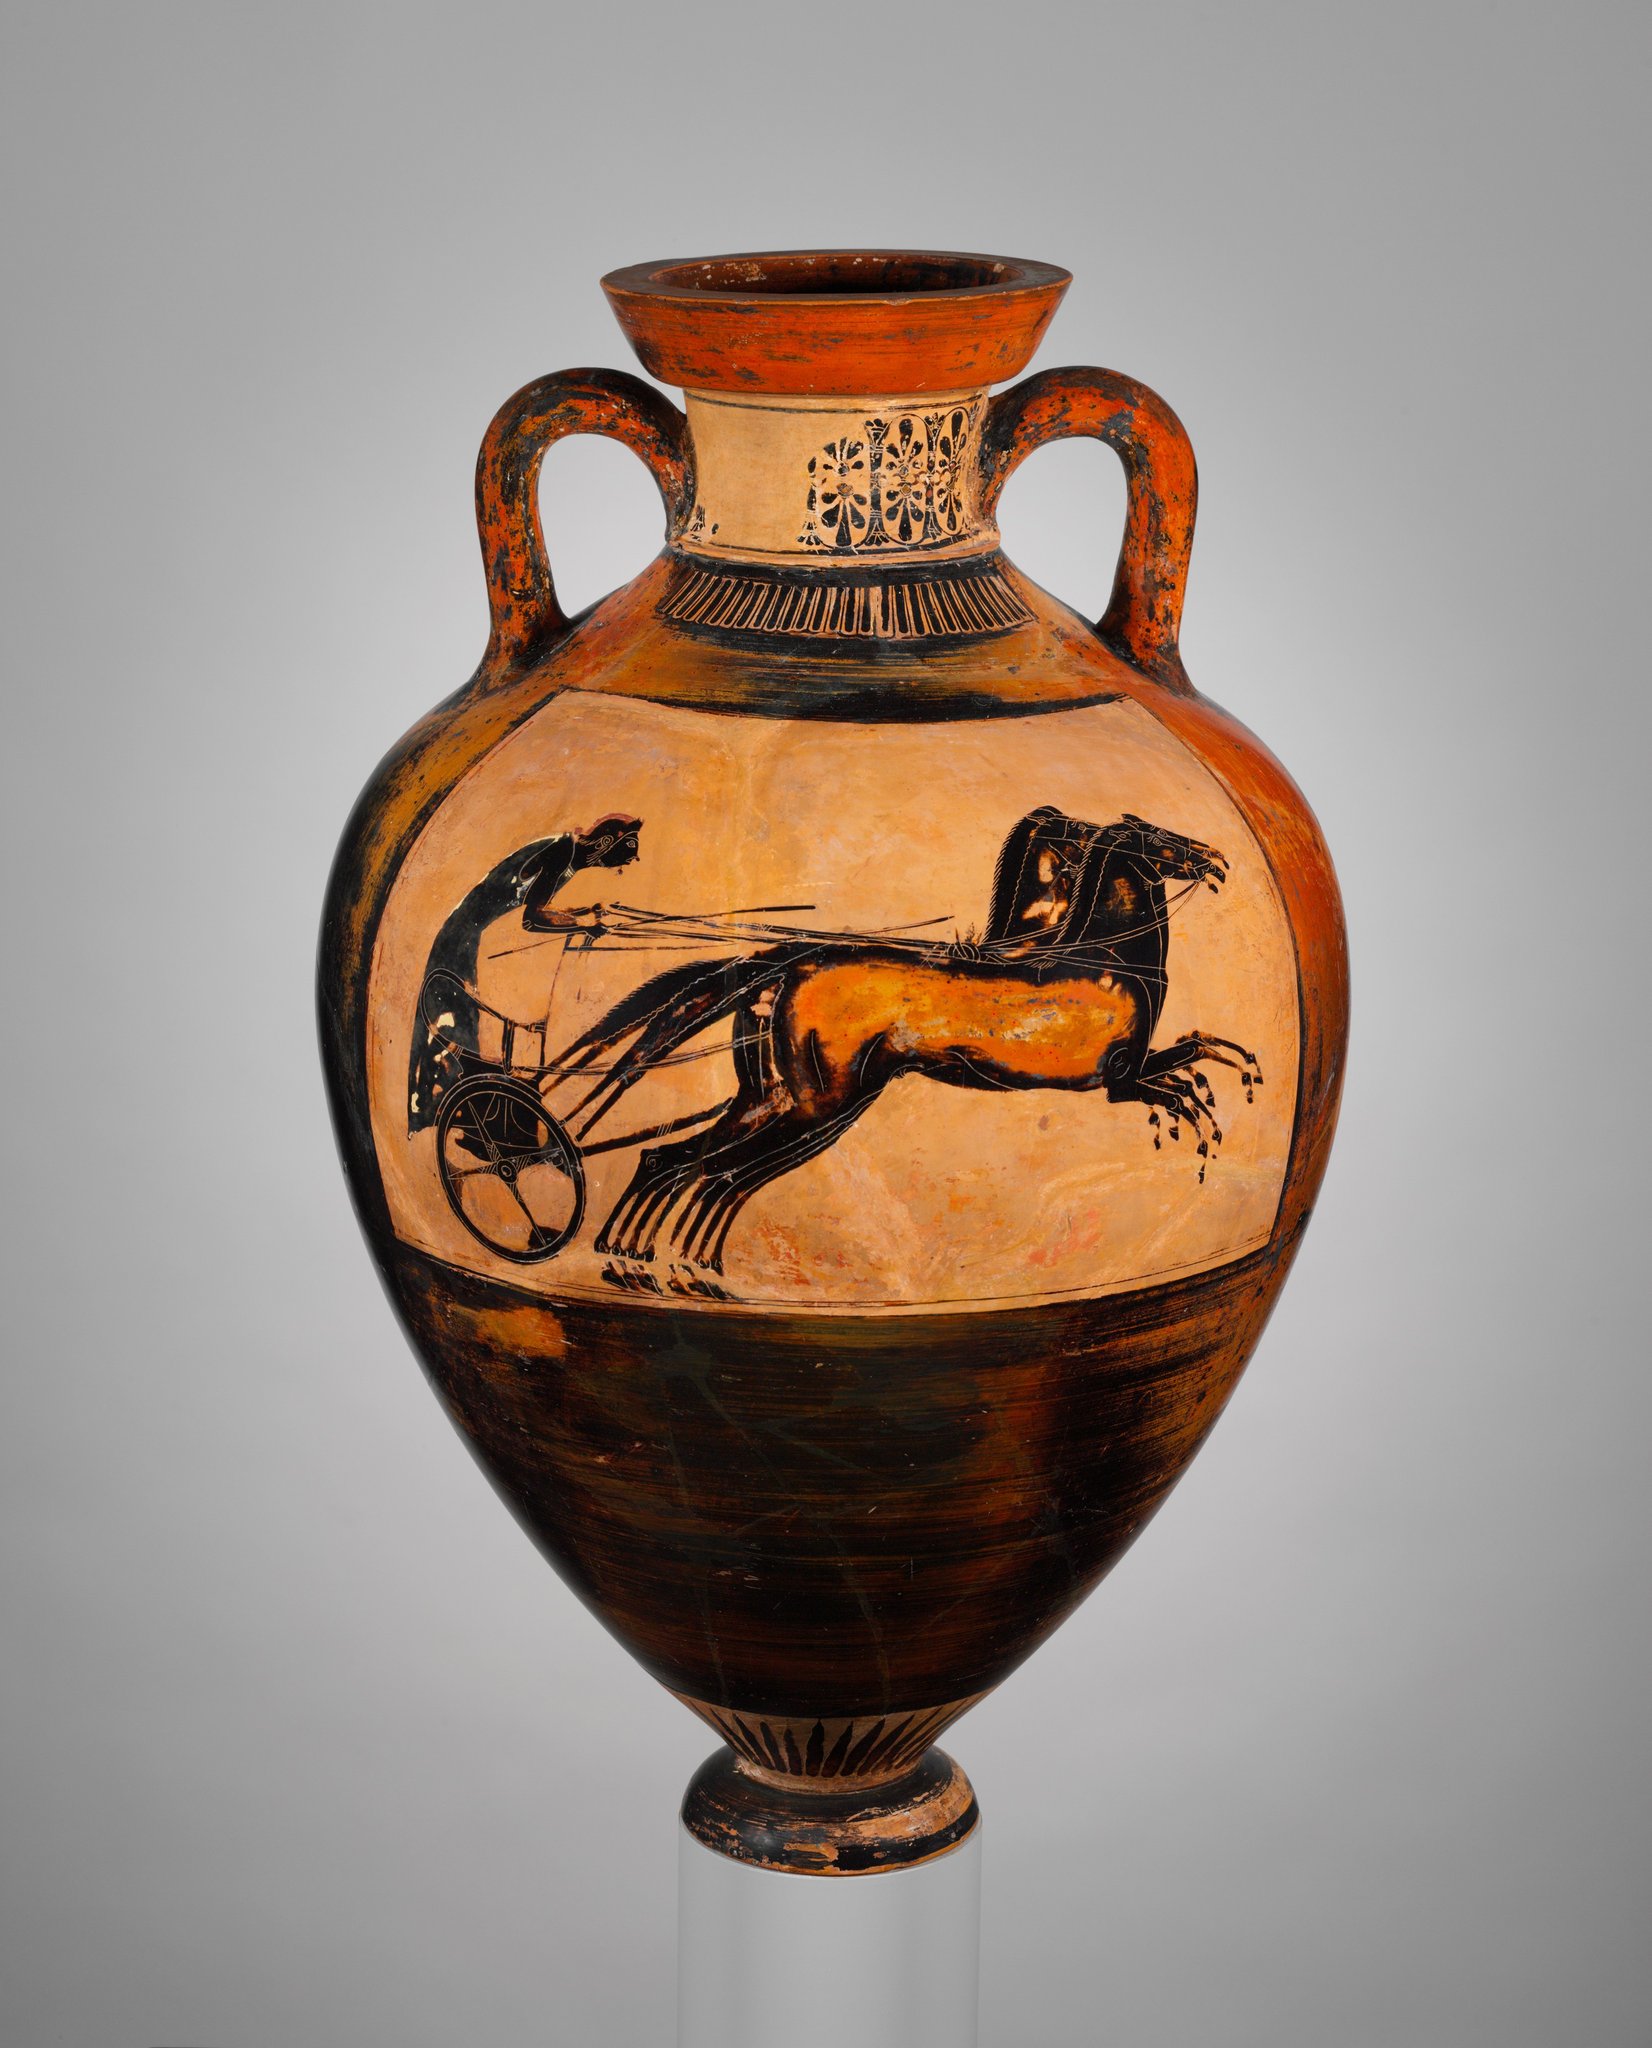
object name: panathenaic prize amphora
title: Terracotta Panathenaic prize amphora (jar)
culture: greek, attic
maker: group of copenhagen 99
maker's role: artist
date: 530 BCE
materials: terracotta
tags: shields,athena,horses,chariots